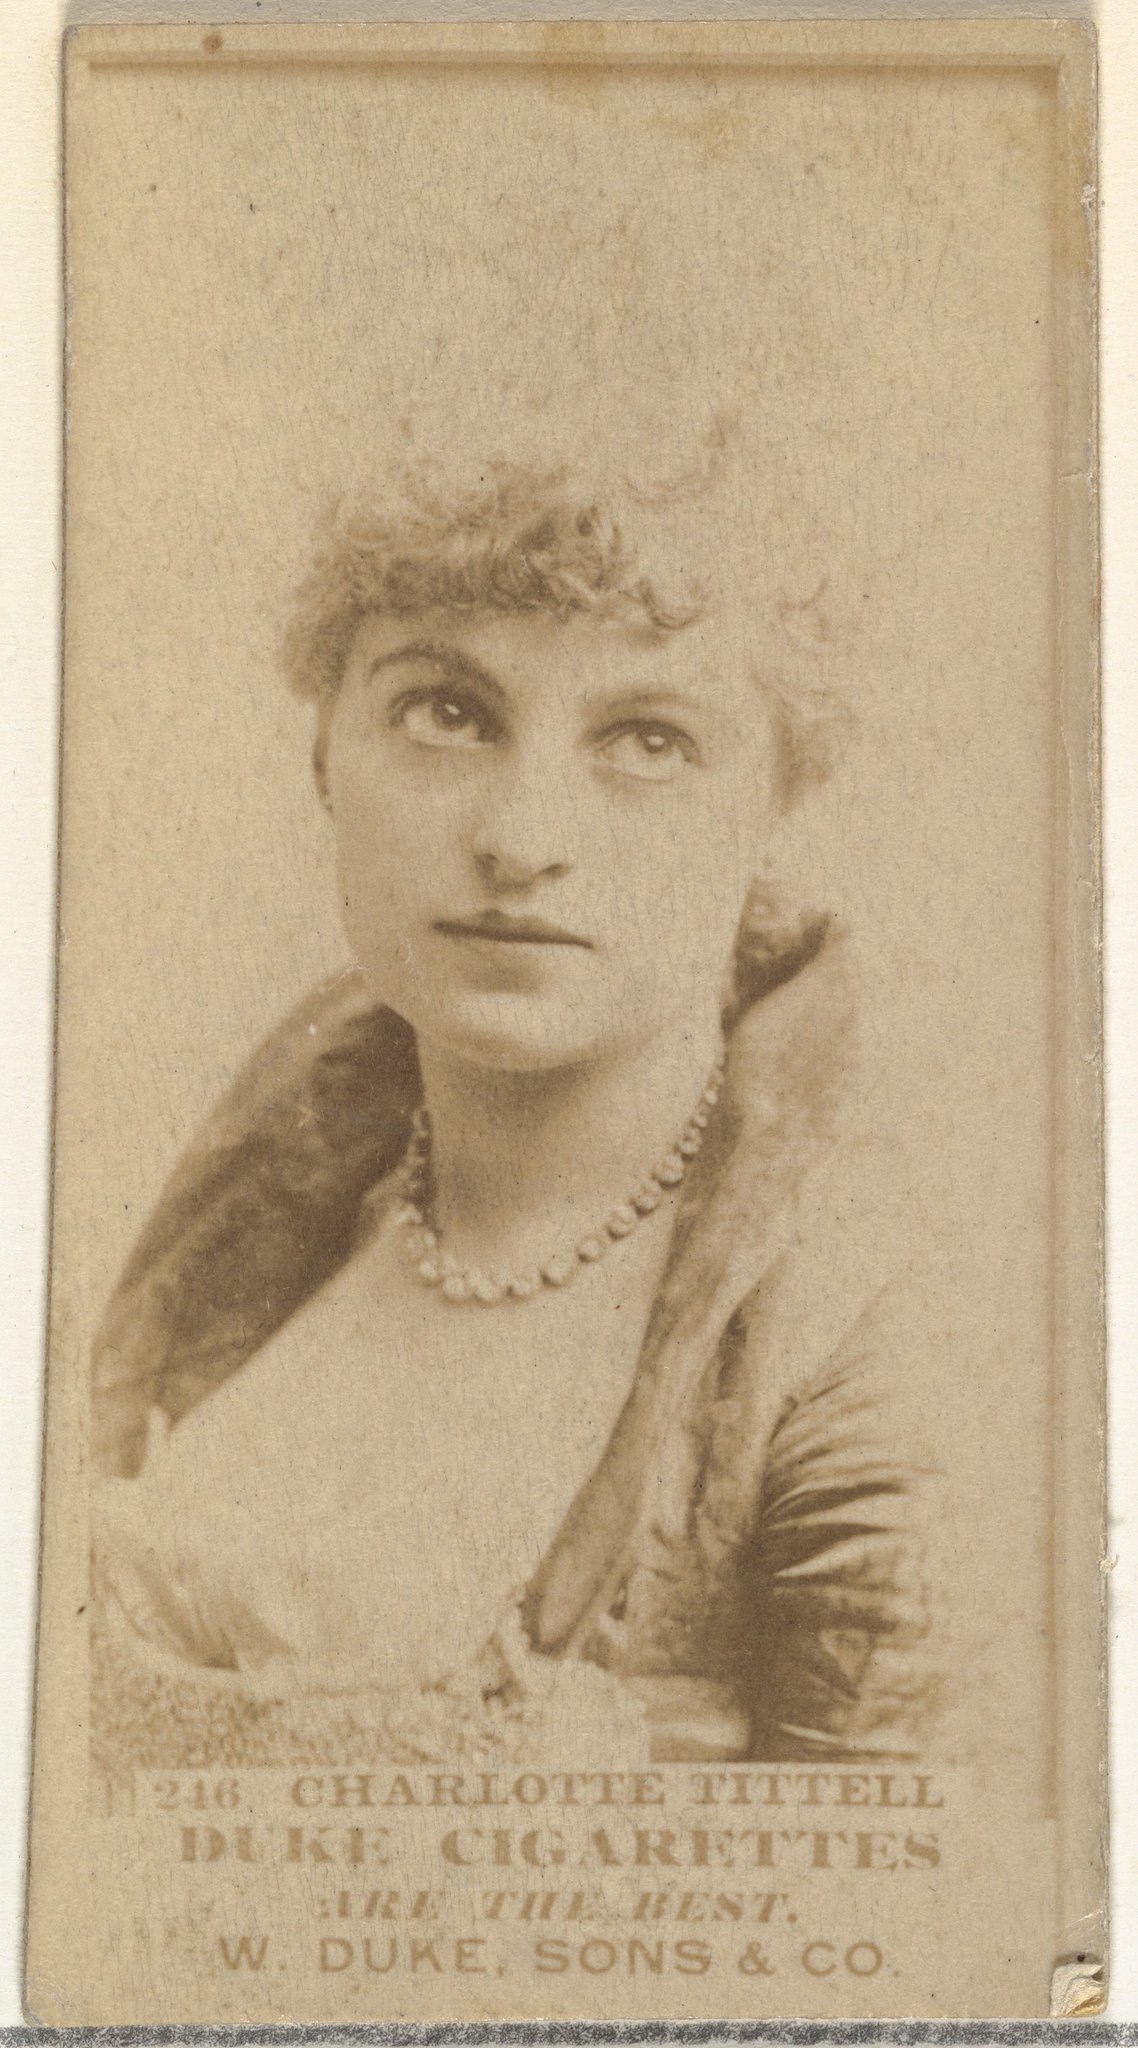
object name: photograph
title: Card Number 246, Charlotte Tittell, from the Actors and Actresses series (N145-7) issued by Duke Sons & Co. to promote Duke Cigarettes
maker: w. duke, sons & co.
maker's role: publisher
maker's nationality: american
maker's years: 1870-1920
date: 1880-1889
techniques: albumen silver print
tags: portraits,women,actresses